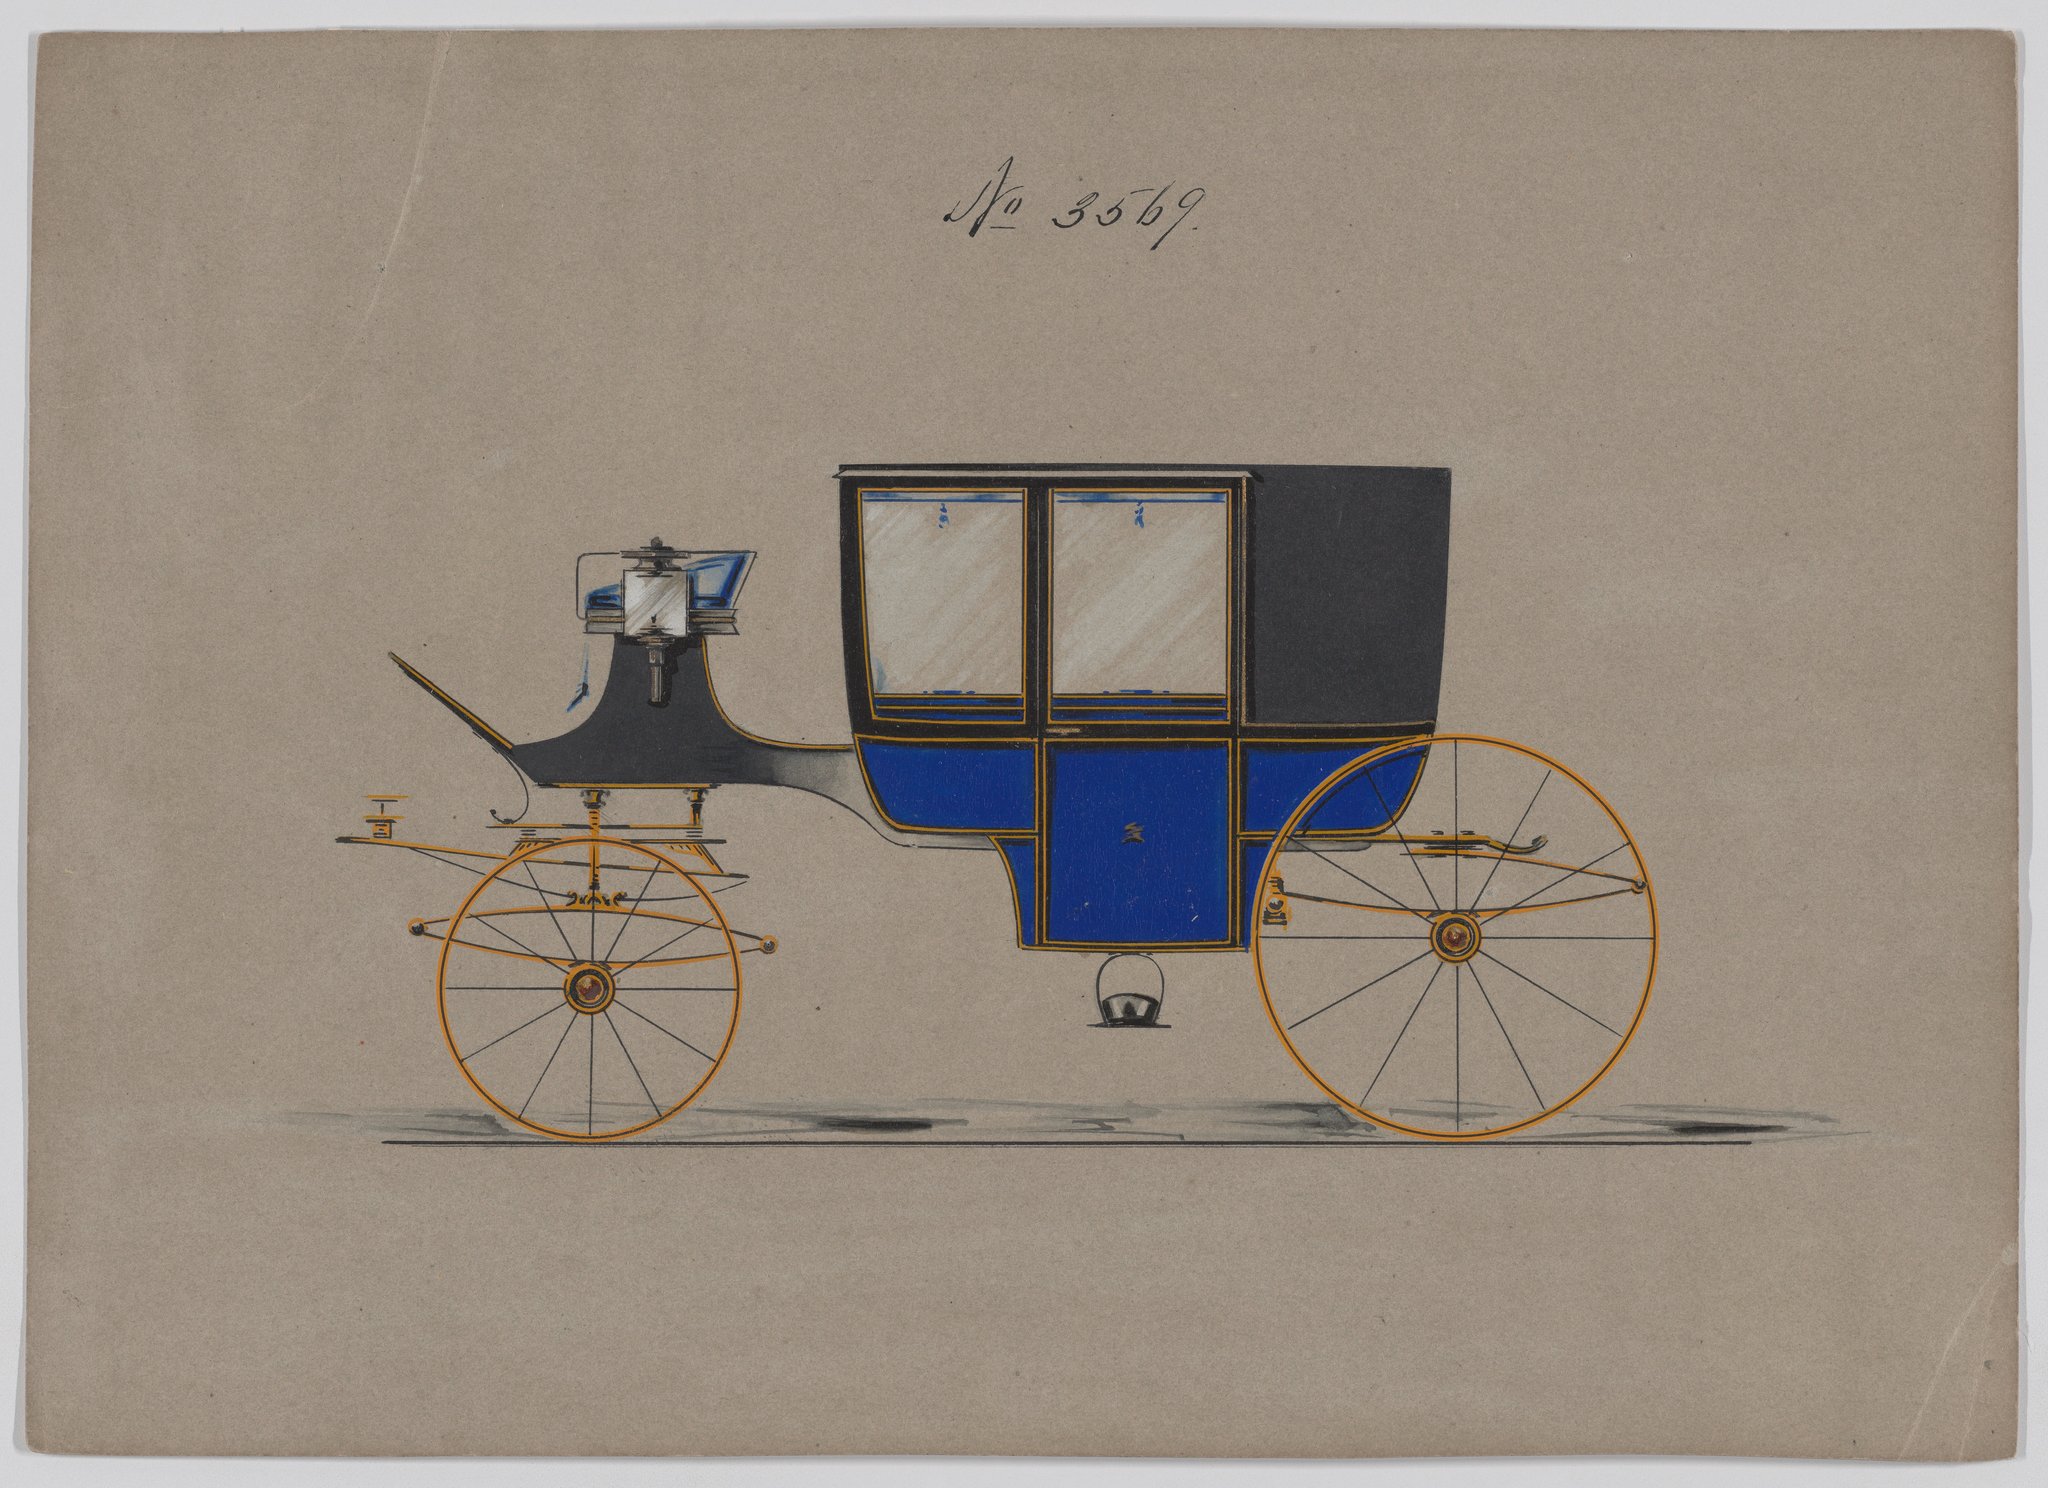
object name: drawing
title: Coach #3569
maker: brewster & co.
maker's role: manufacturer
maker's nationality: american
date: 1880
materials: gouache, gum arabic, ink, watercolor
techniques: pen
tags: carriages